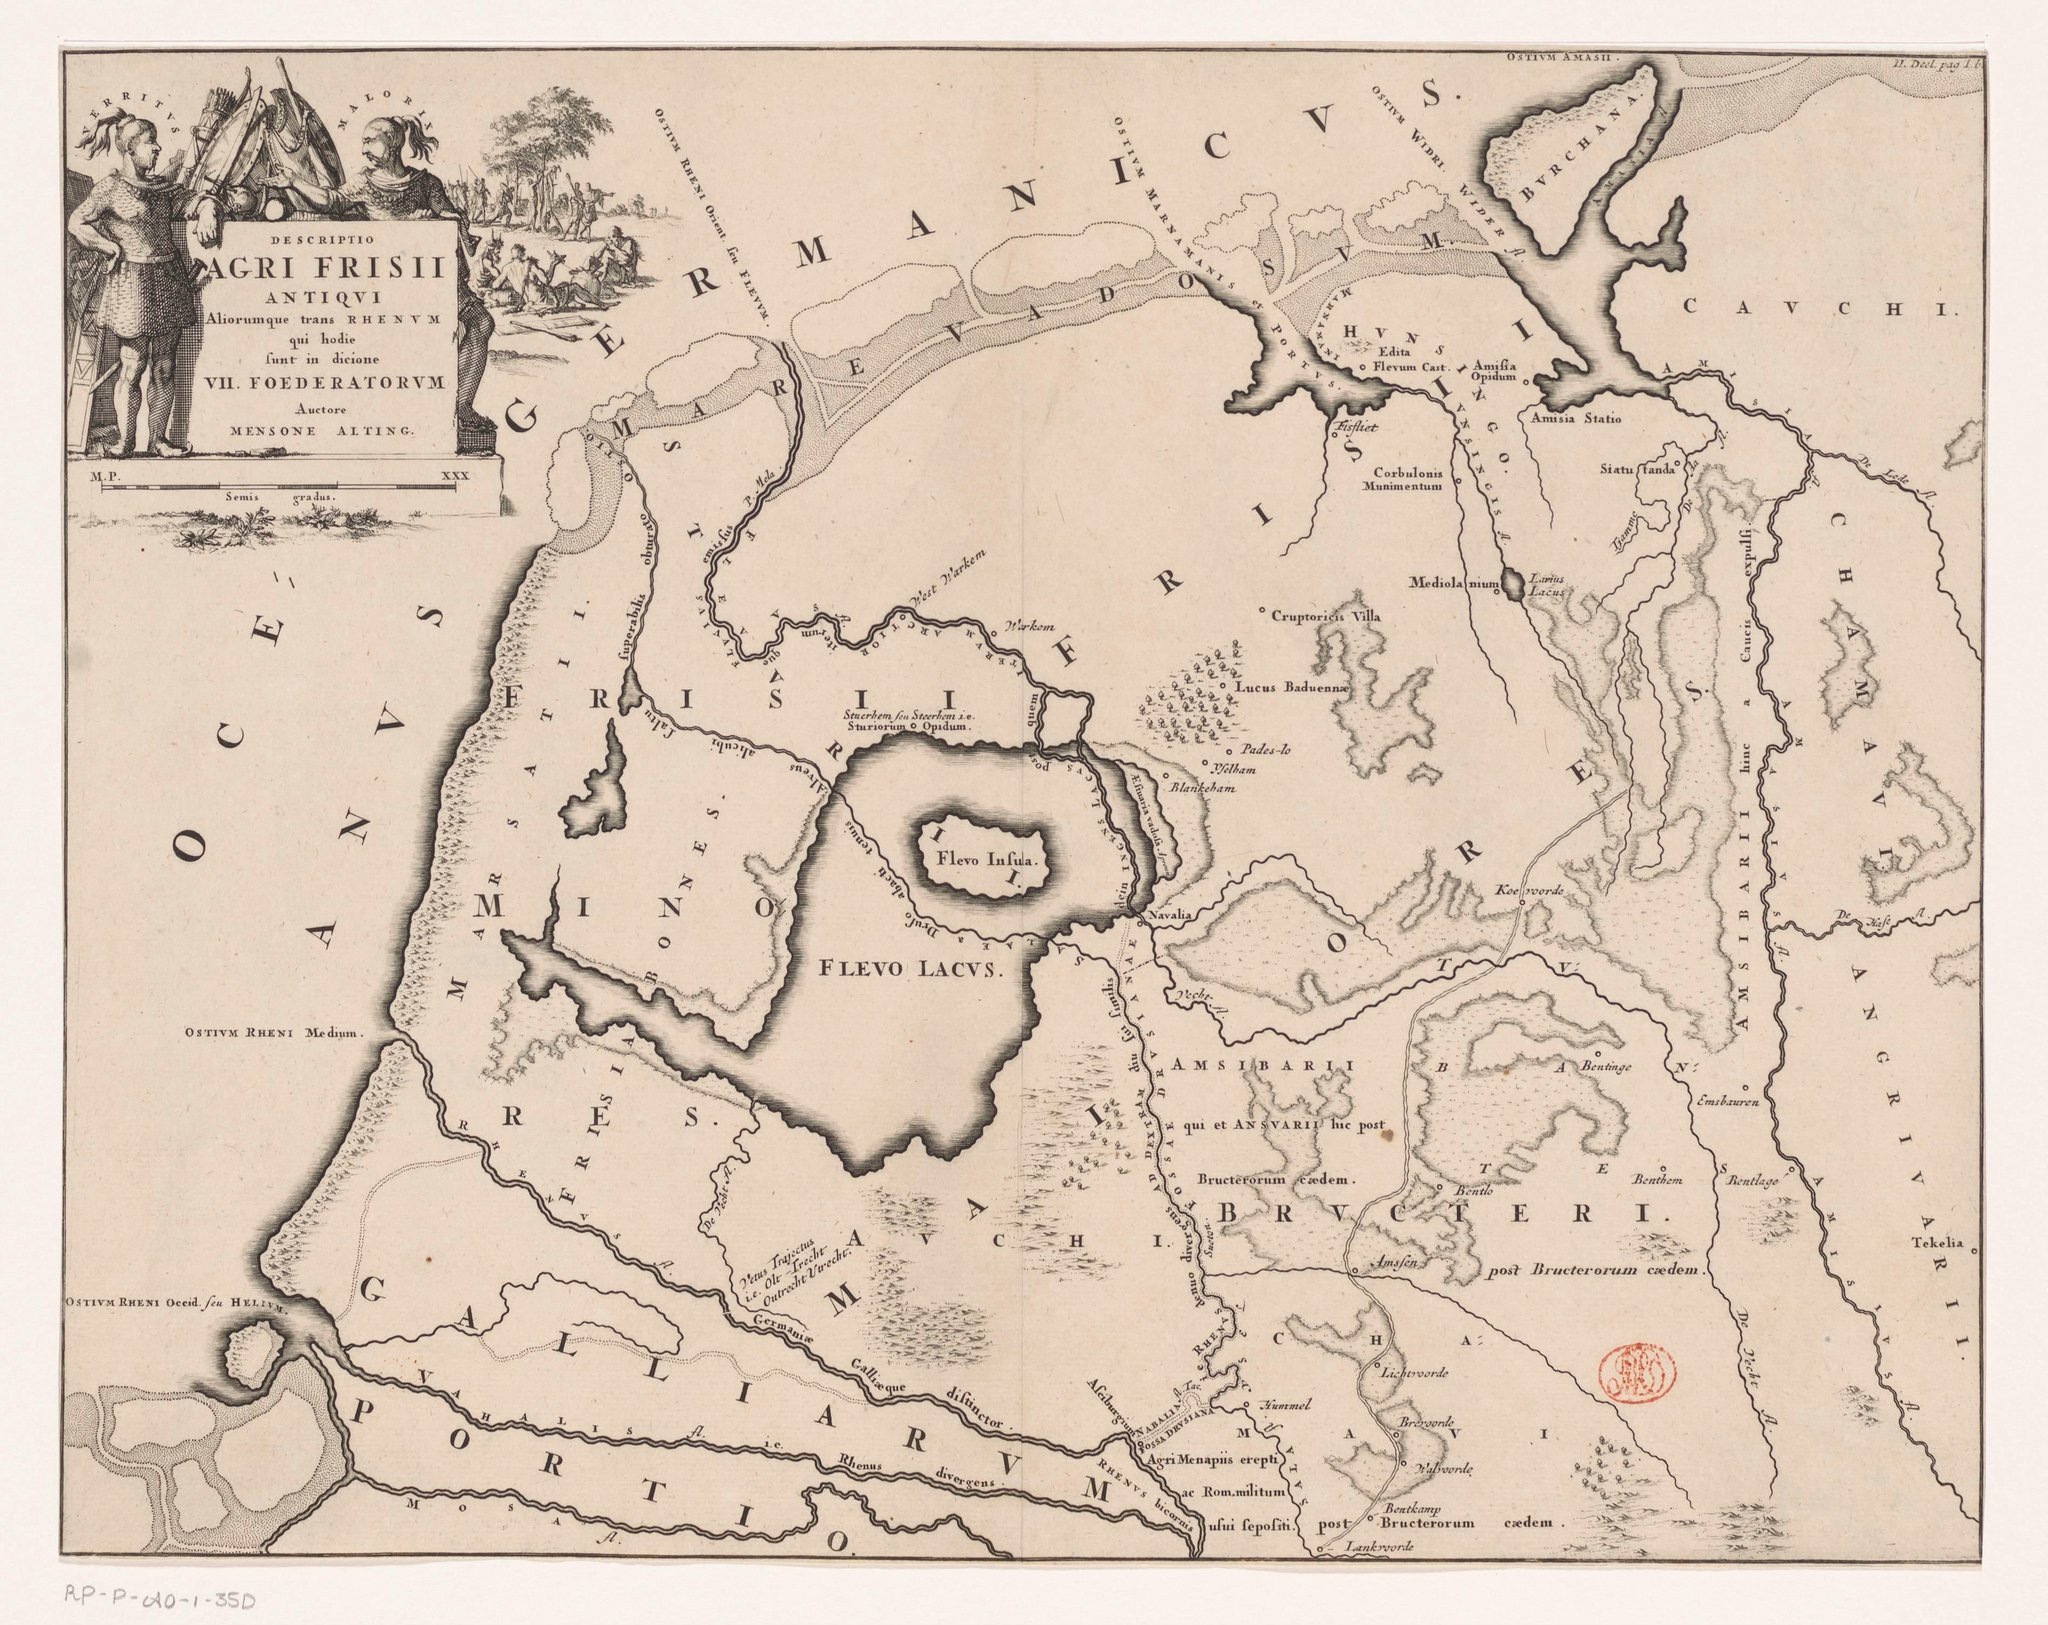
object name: history print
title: Descriptio agri Frisii Antiqui (...)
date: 1697-1700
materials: paper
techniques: engraving, etching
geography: netherlands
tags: maps of separate countries or regions, netherlands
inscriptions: collector's mark: Lugt 195, collector's mark: Lugt 2228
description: Maakt deel uit van 16 kaarten van het land van de Bataven en de Friezen eerst vervaardigd voor en opgenomen in Alting, Menso. Descriptio, secundum antiquos, agri Batavi & Frisii. 2 delen. Amsterdam: Henricus Wetstein, 1697-1700. Hergebruikt in Halma, François. Tooneel der Vereenigde Nederlanden, en onderhorige landschappen (...). 2 delen. Leeuwarden: Hendrik Halma, 1725. Deze kaart is gebruikt in Halma's Tooneel der Vereenigde Nederlanden (1725) en is volgens opschrift rechtsboven te vinden in deel 2, p. 1b.